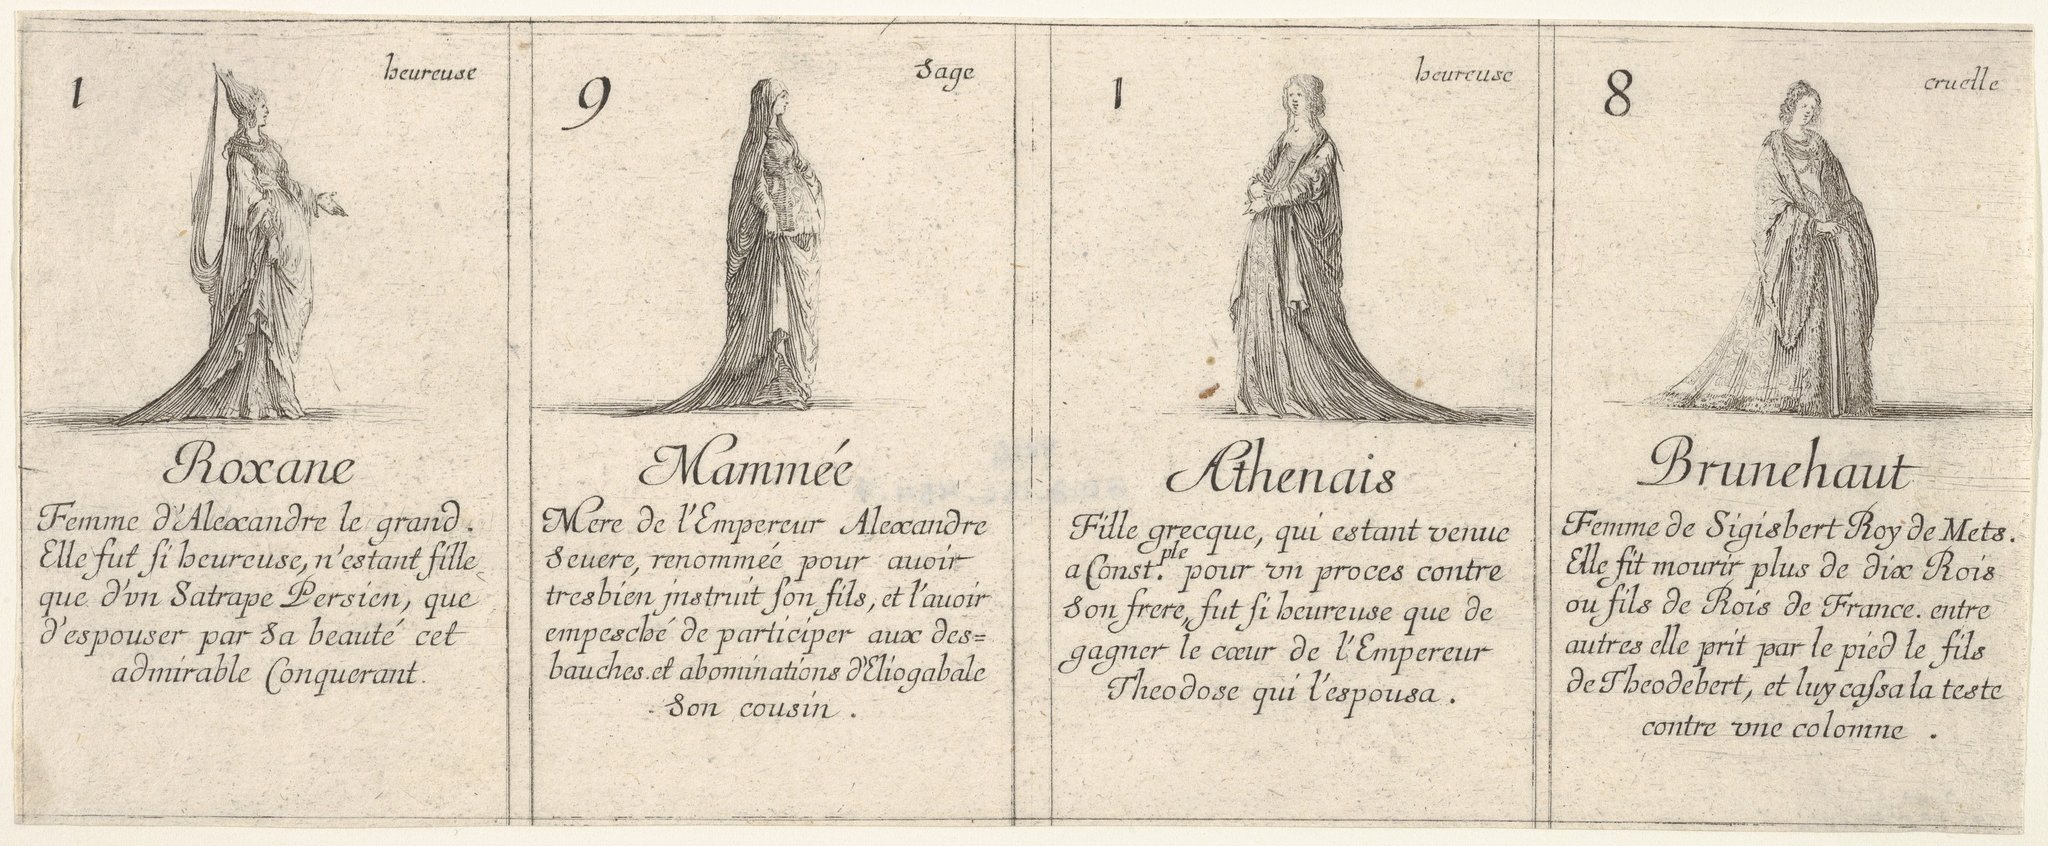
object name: print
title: Roxane, Mammée, Athenais, and Brunehaut, from "The Game of Queens" (Le Jeu des Reines Renommées)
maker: stefano della bella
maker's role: artist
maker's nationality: italian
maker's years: 1610-1664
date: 1644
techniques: etching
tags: women